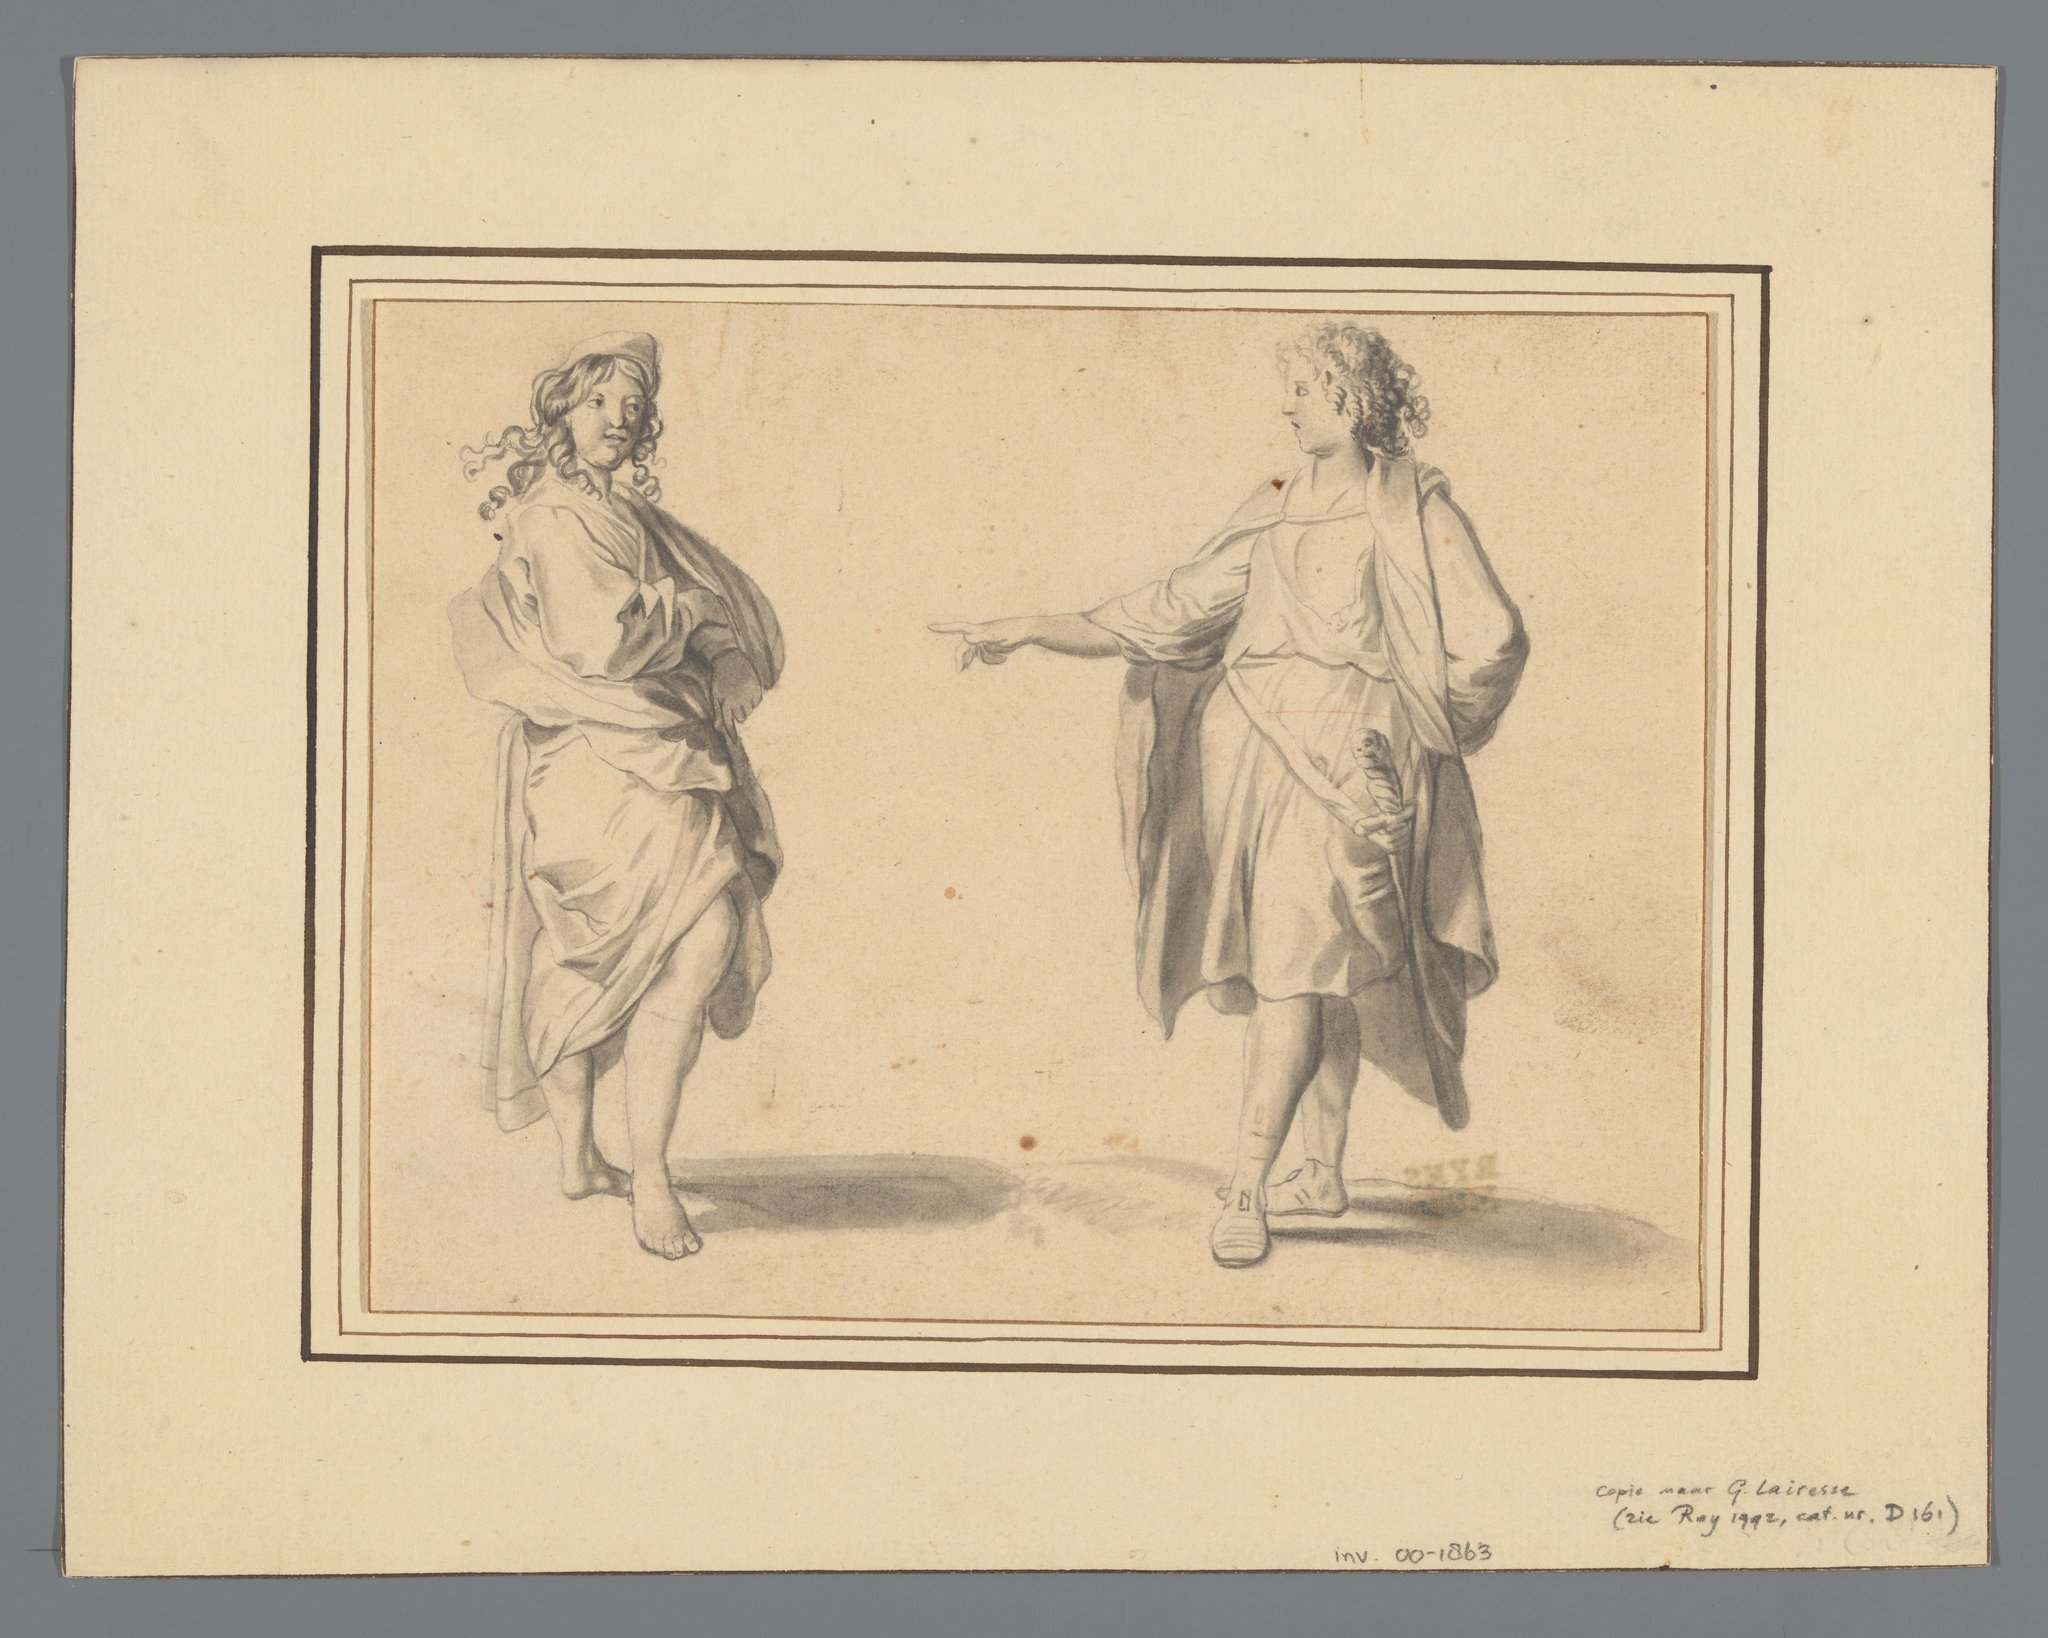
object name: drawing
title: Twee staande figuren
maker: Anonymous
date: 1651-1761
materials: paper, pencil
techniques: brush